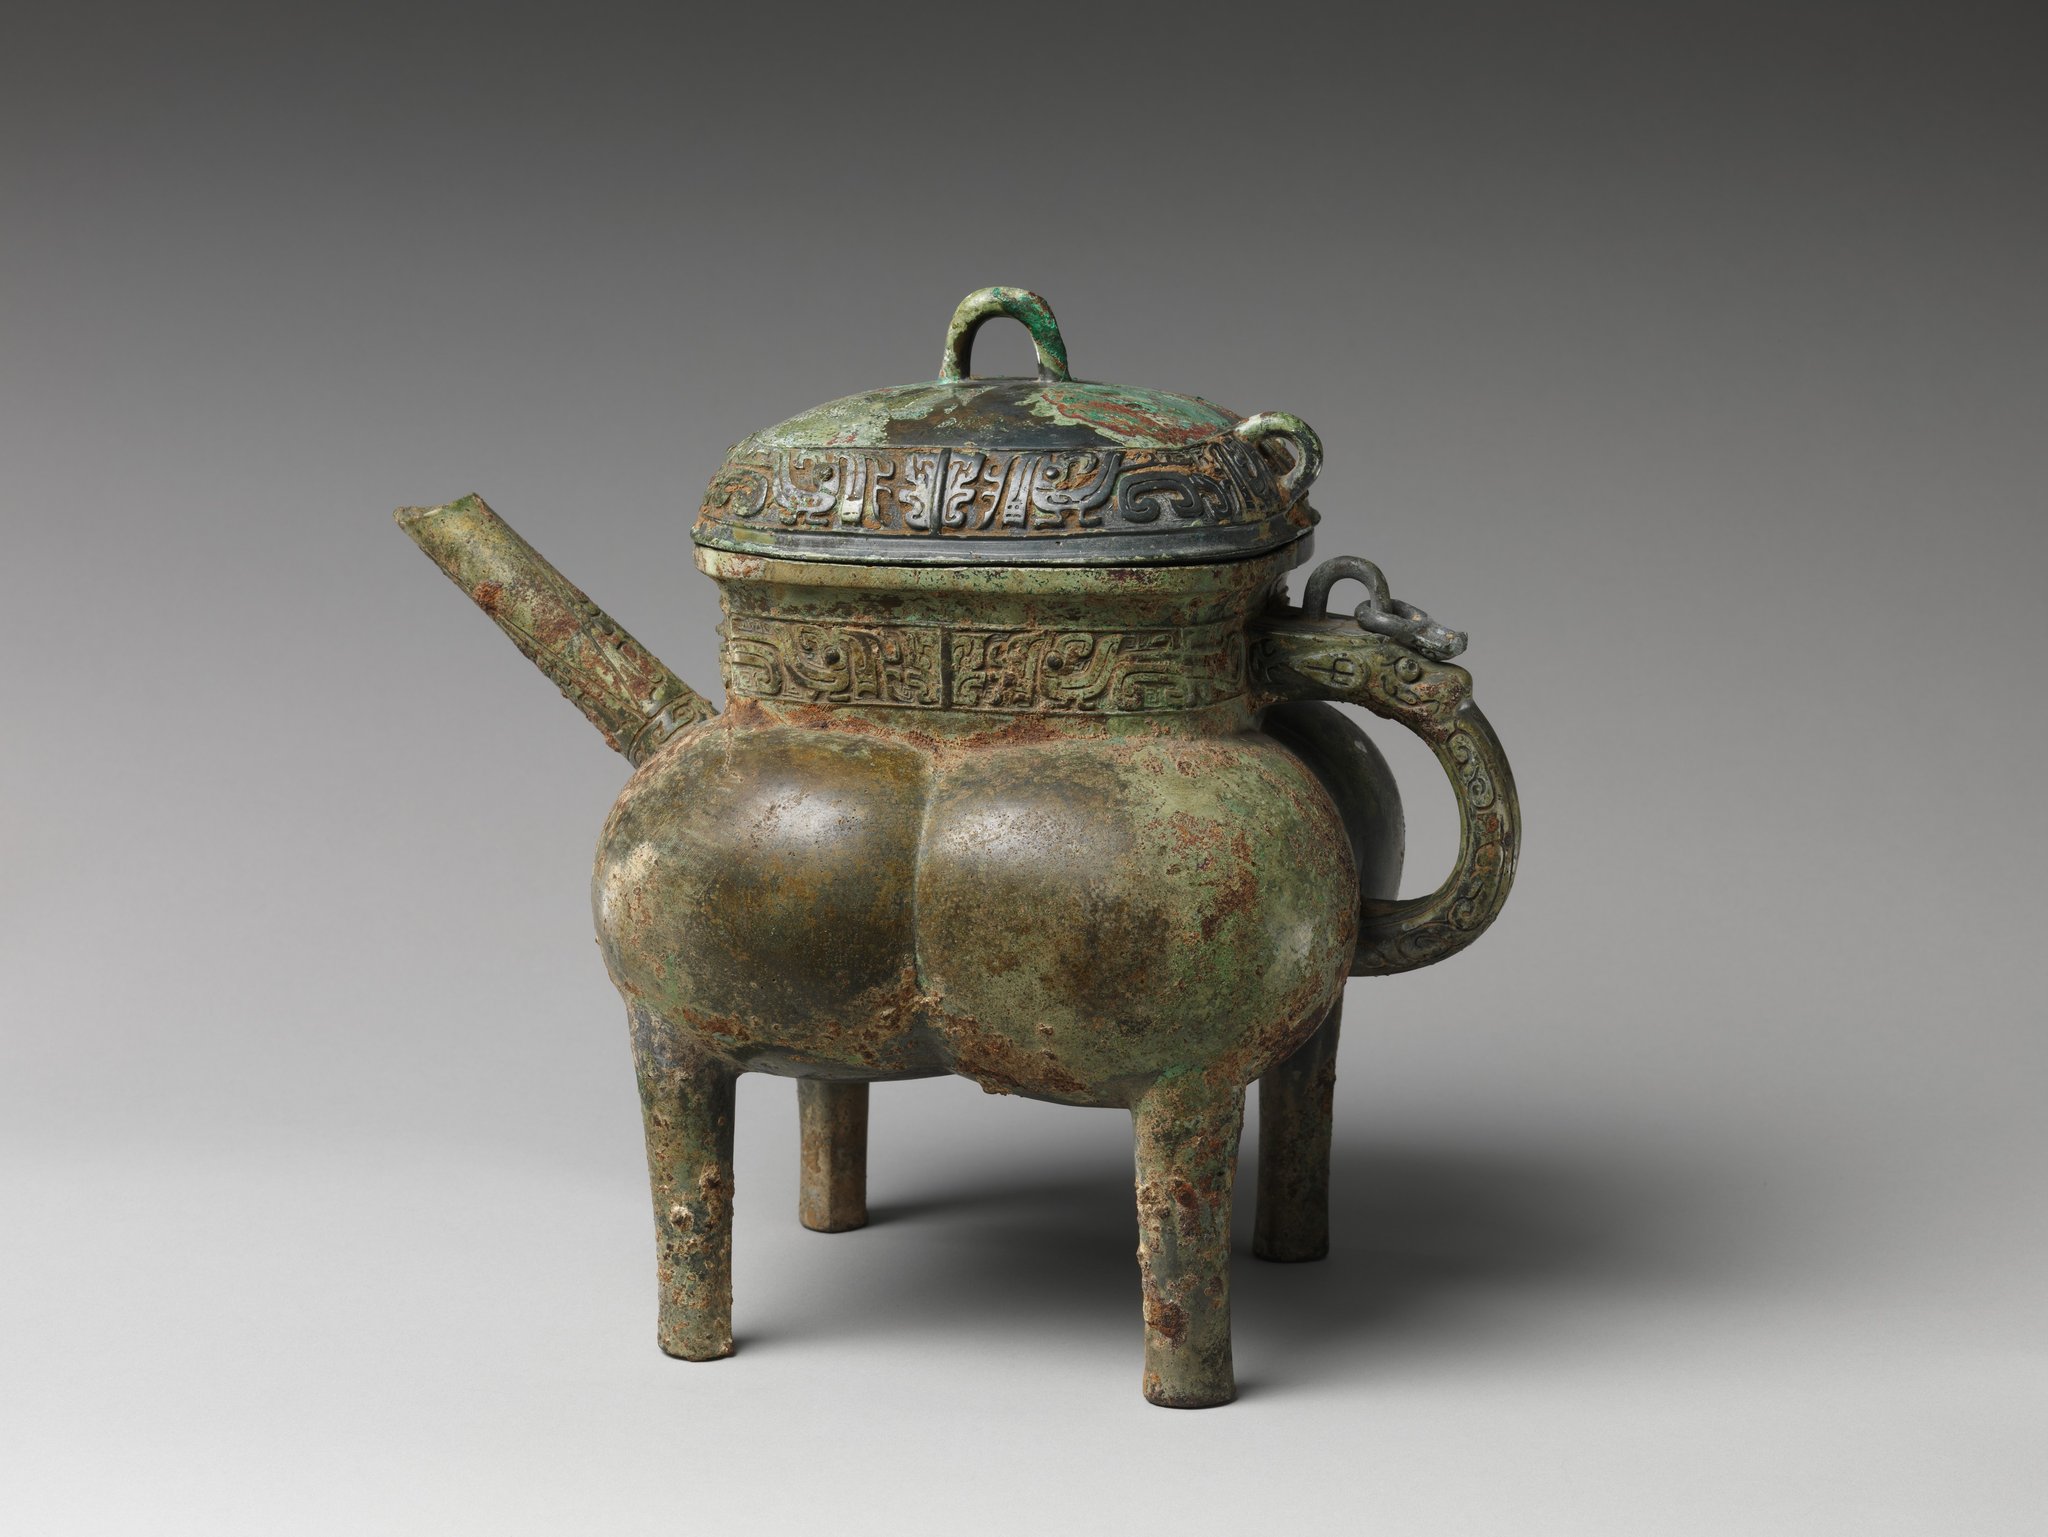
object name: water container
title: Spouted water container (He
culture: chinese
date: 1100-1001 BCE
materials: bronze